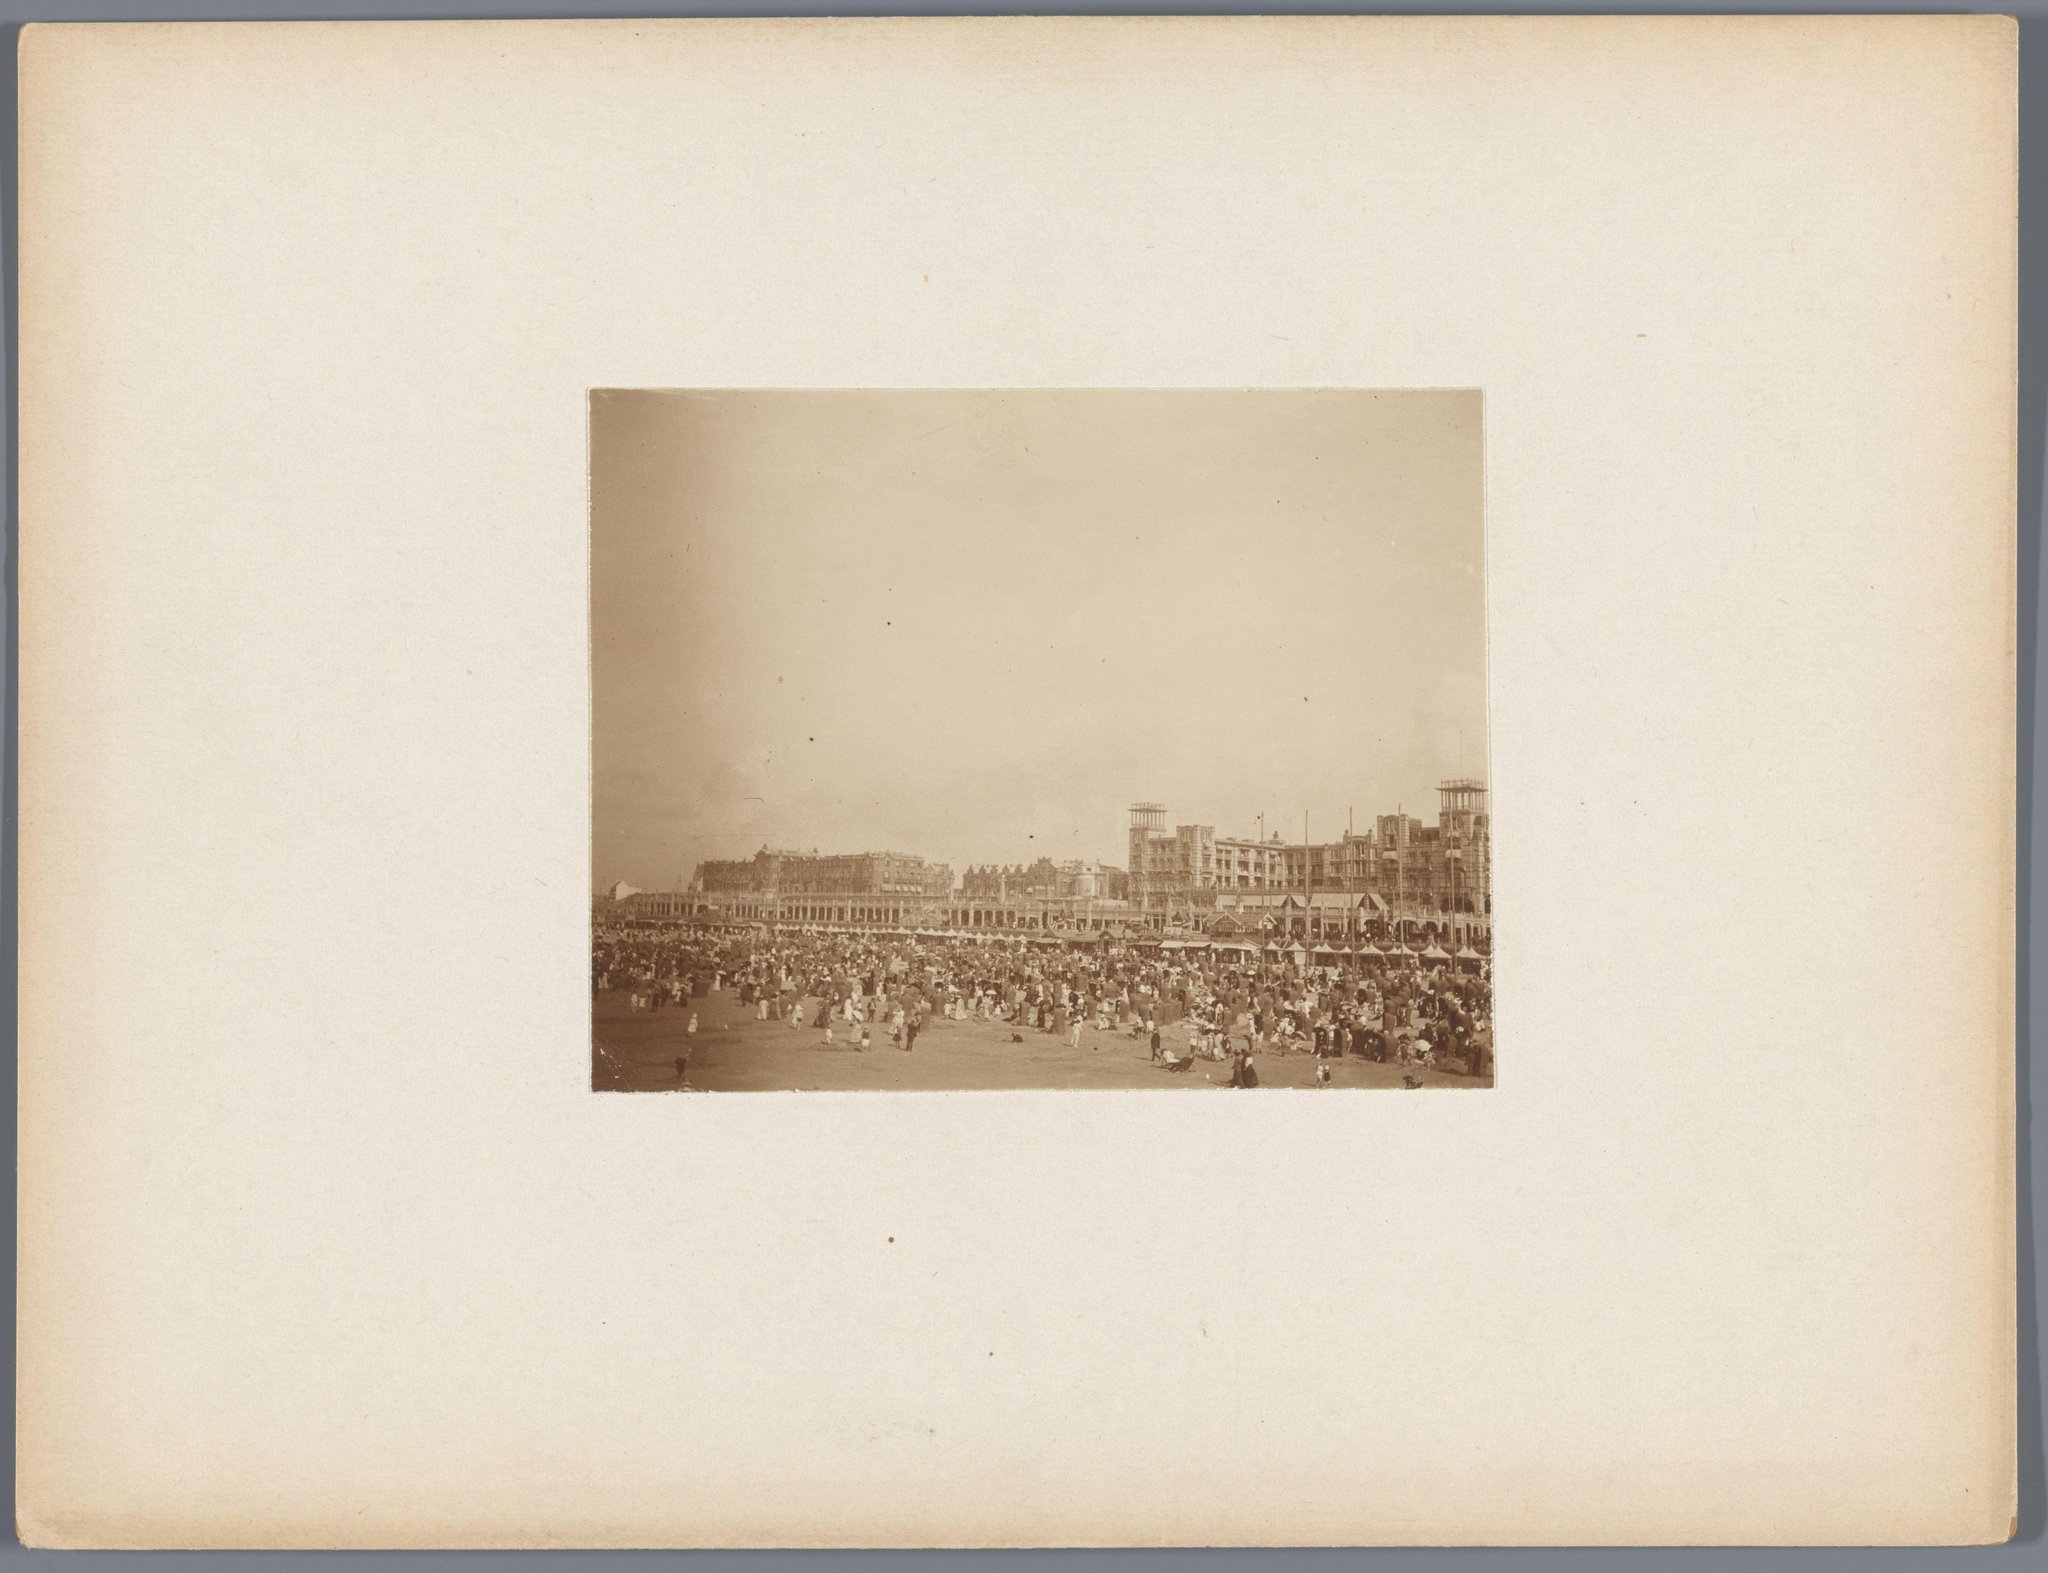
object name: photograph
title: Strand bij Scheveningen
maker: Anonymous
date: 1907-1910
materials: cardboard, photographic support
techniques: collodion silver print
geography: scheveningen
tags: beach (as place of recreation)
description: Strand bij Scheveningen. Onderdeel van het losbladige fotoalbum met 39 foto's van een reis door Nederland, ca. 1907-1910.